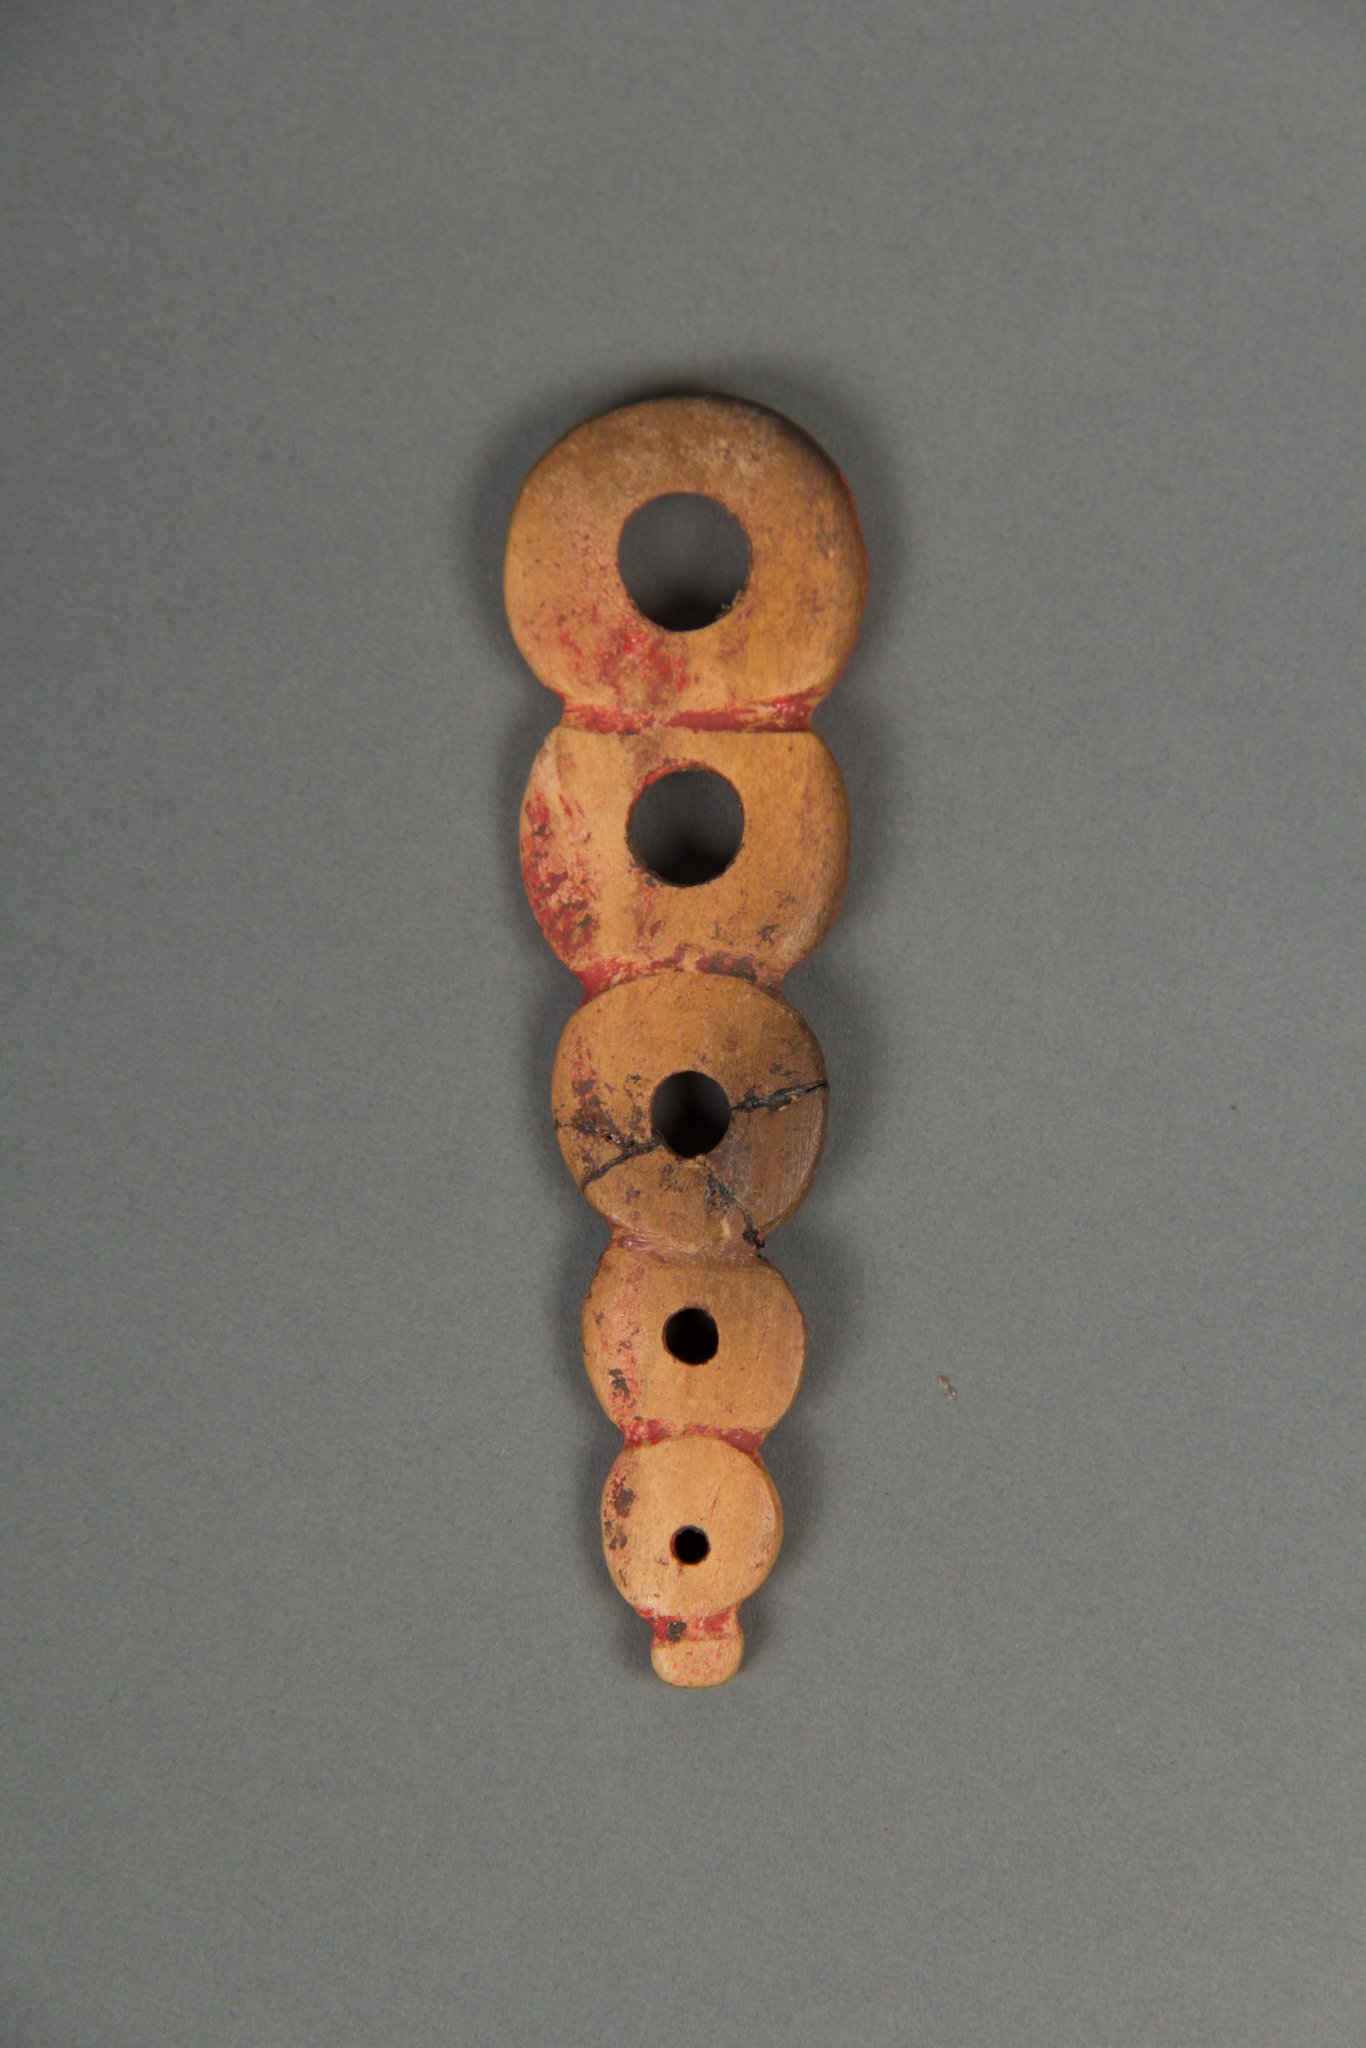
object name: ornament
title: Body Ornament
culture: japanese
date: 1000-300 BCE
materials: bone